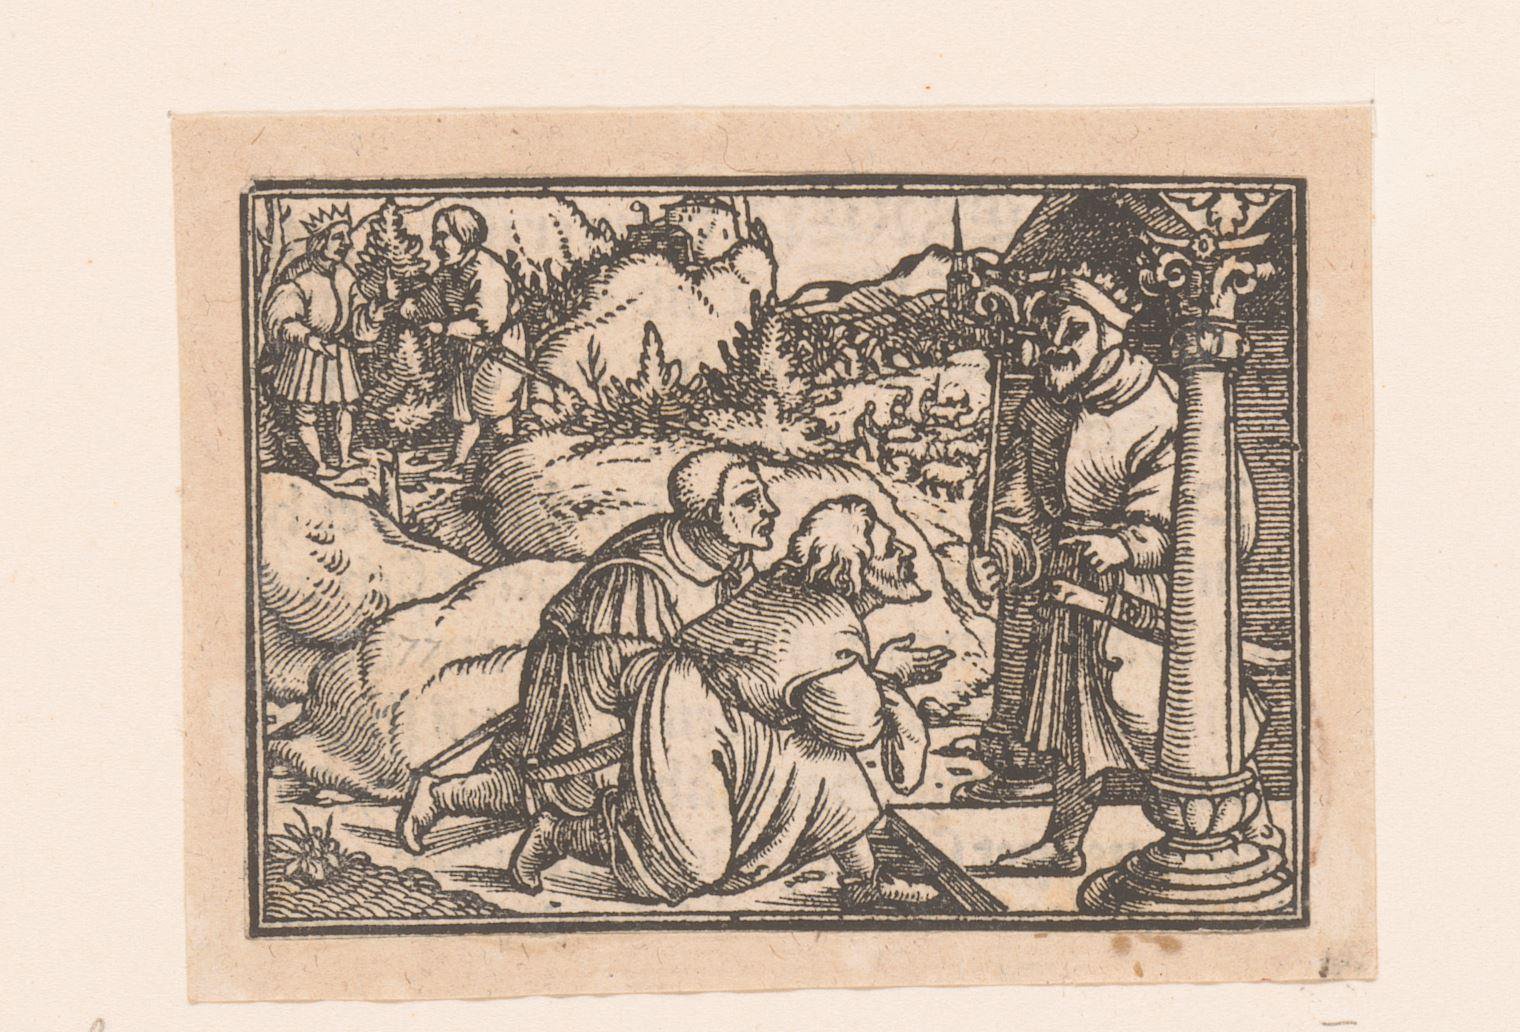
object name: book illustration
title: Twee mannen knielen voor een koning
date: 1522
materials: paper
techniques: woodcut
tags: kneeling before a ruler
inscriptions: collector's mark: Lugt 240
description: Mogelijk een kopie van een prent van Hans Holbein de jongere. Niet uit de Icones historiarum Veteris Testamenti van 1538. Deze kopie mogelijk uit: Biblia sacra iuxta vulgatam. Parijs: Jean Benoît, 1552. Ook aanwezig in de Herzog August Bibliothek: http://diglib.hab.de?grafik=graph-res-d-326-1.